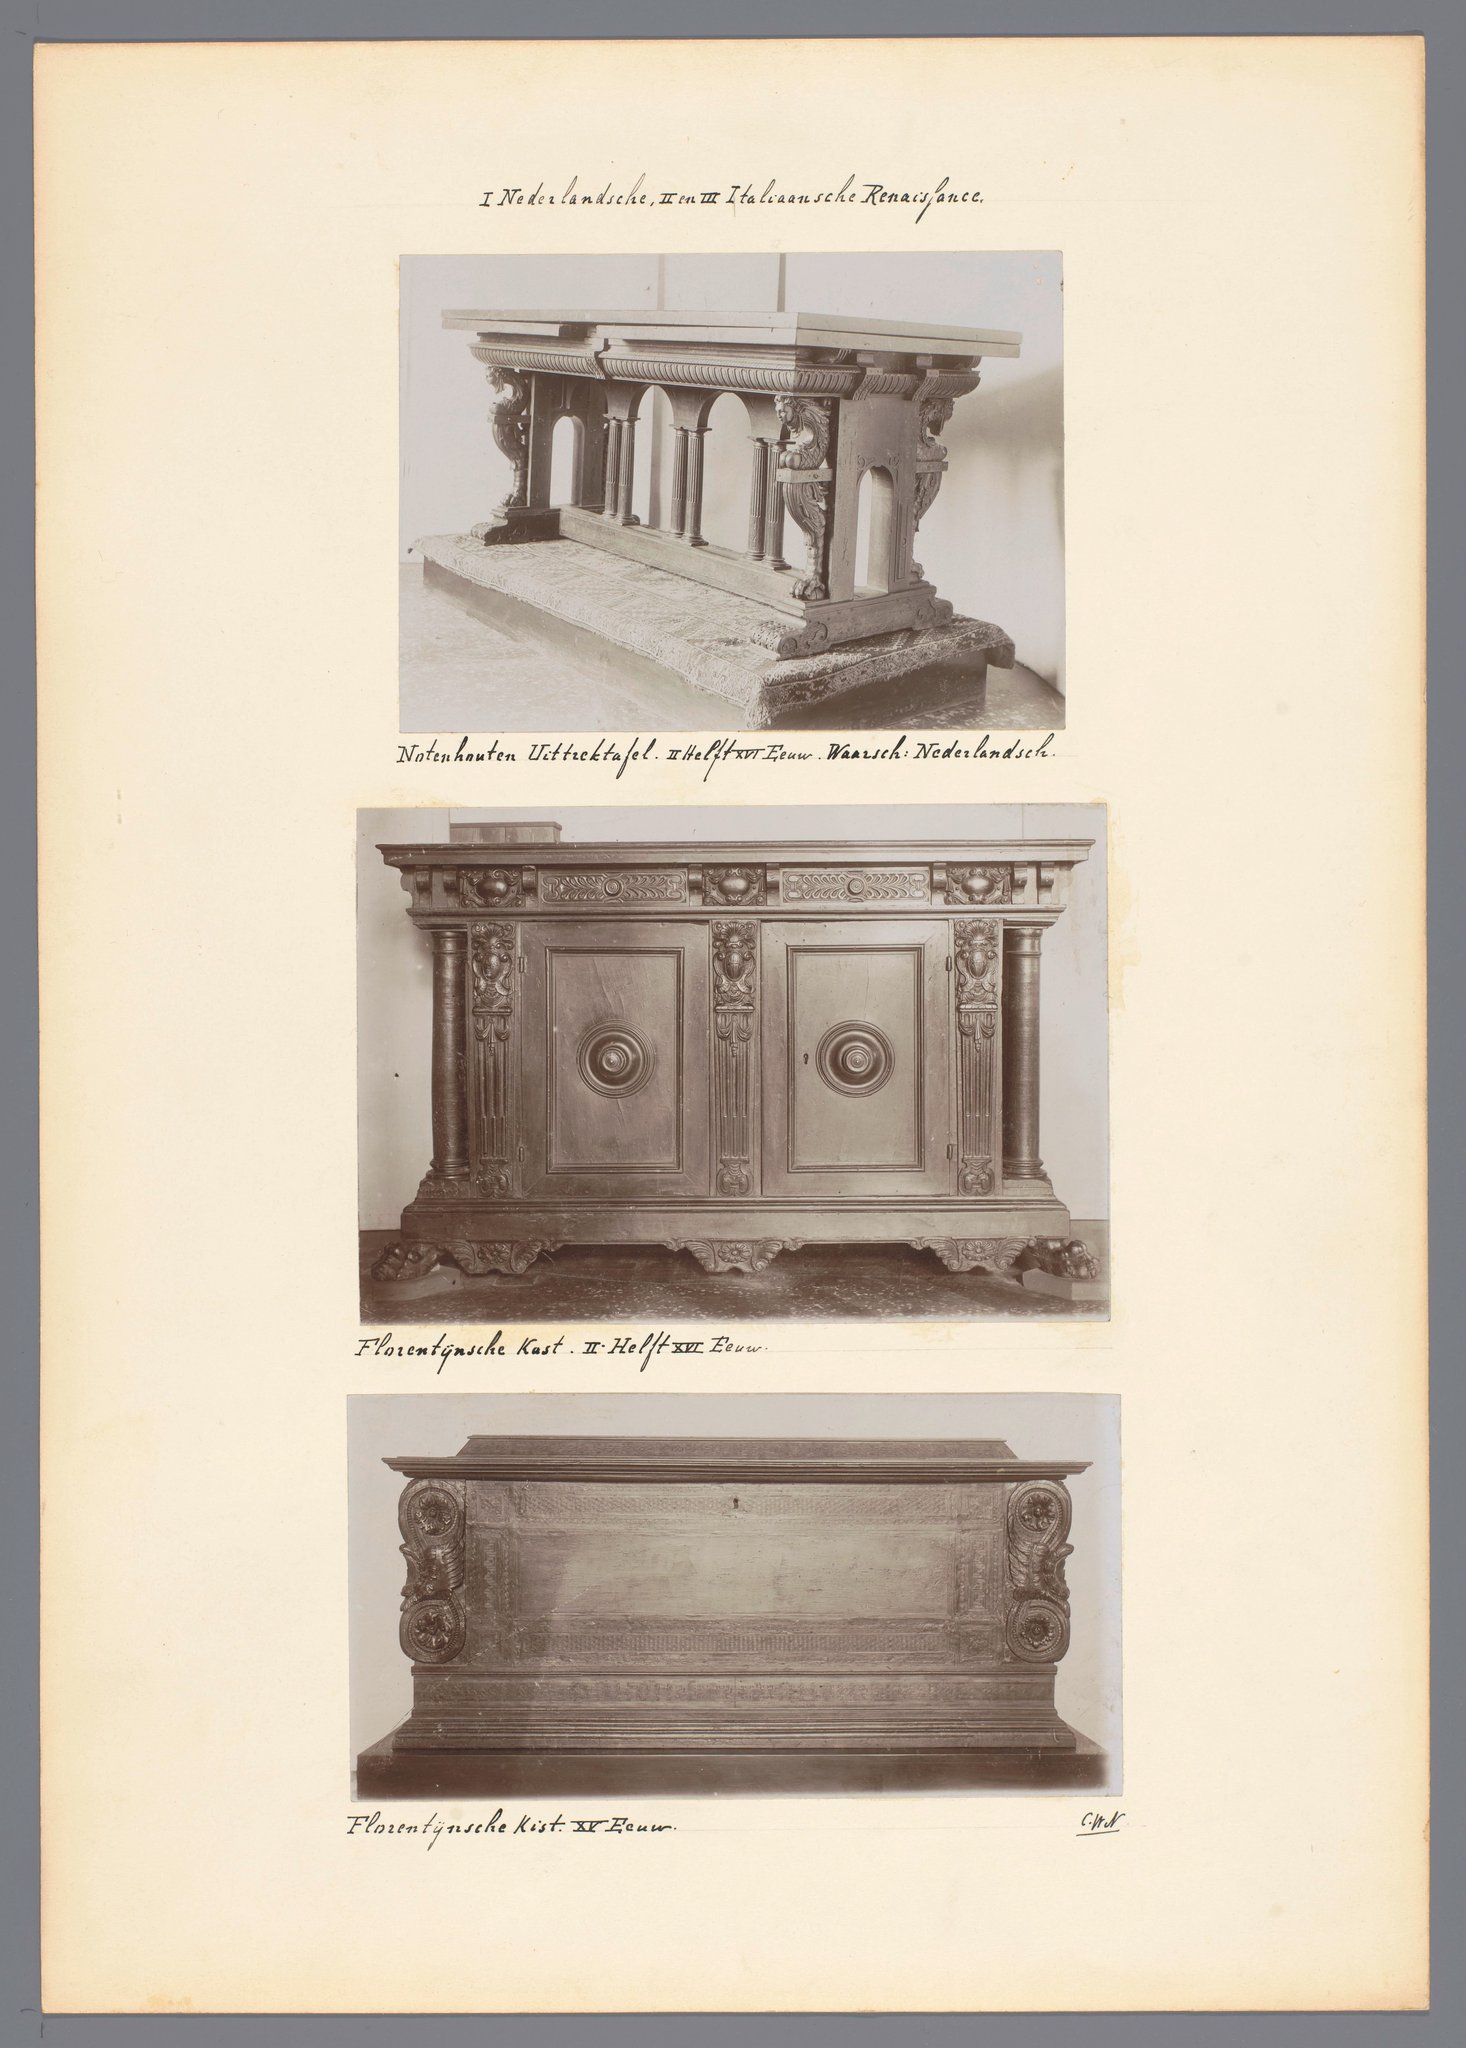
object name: photograph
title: Drie meubels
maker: Anonymous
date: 1875-1900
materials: cardboard, photographic support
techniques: collodion silver print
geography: europe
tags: coat of arms (as symbol of the state, etc.), ornament ~ hybrid animals, column, pillar ~ architecture, monsters of the sea, table, chest, coffer, cupboard, flowers ~ ornament, europe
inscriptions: collector's mark: ‘INSTITUUT VOOR KUNST-NIJVERHEIDSONDERWIJS GABRIËL METSUSTRAAT No. 16 AMSTERDAM’, collector's mark: ‘KUNSTNIJVERHEIDSCHOOL QUELLINUS AMSTERDAM FRANS HALSSTRAAT 14.’, inscription: ‘I Nederlandsche, II en III Italiaansche Renaissance.’, inscription: ‘C.WN’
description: Boven een wangentafel van notenhout met trekbladen gedecoreerd met colonnettten, dierenklauwen en zeewezens, midden een houten kast gedecoreerd met wapenschilden, bloemen en leeuwenpoten, onder een houten kist gedecoreerd met bloemen.